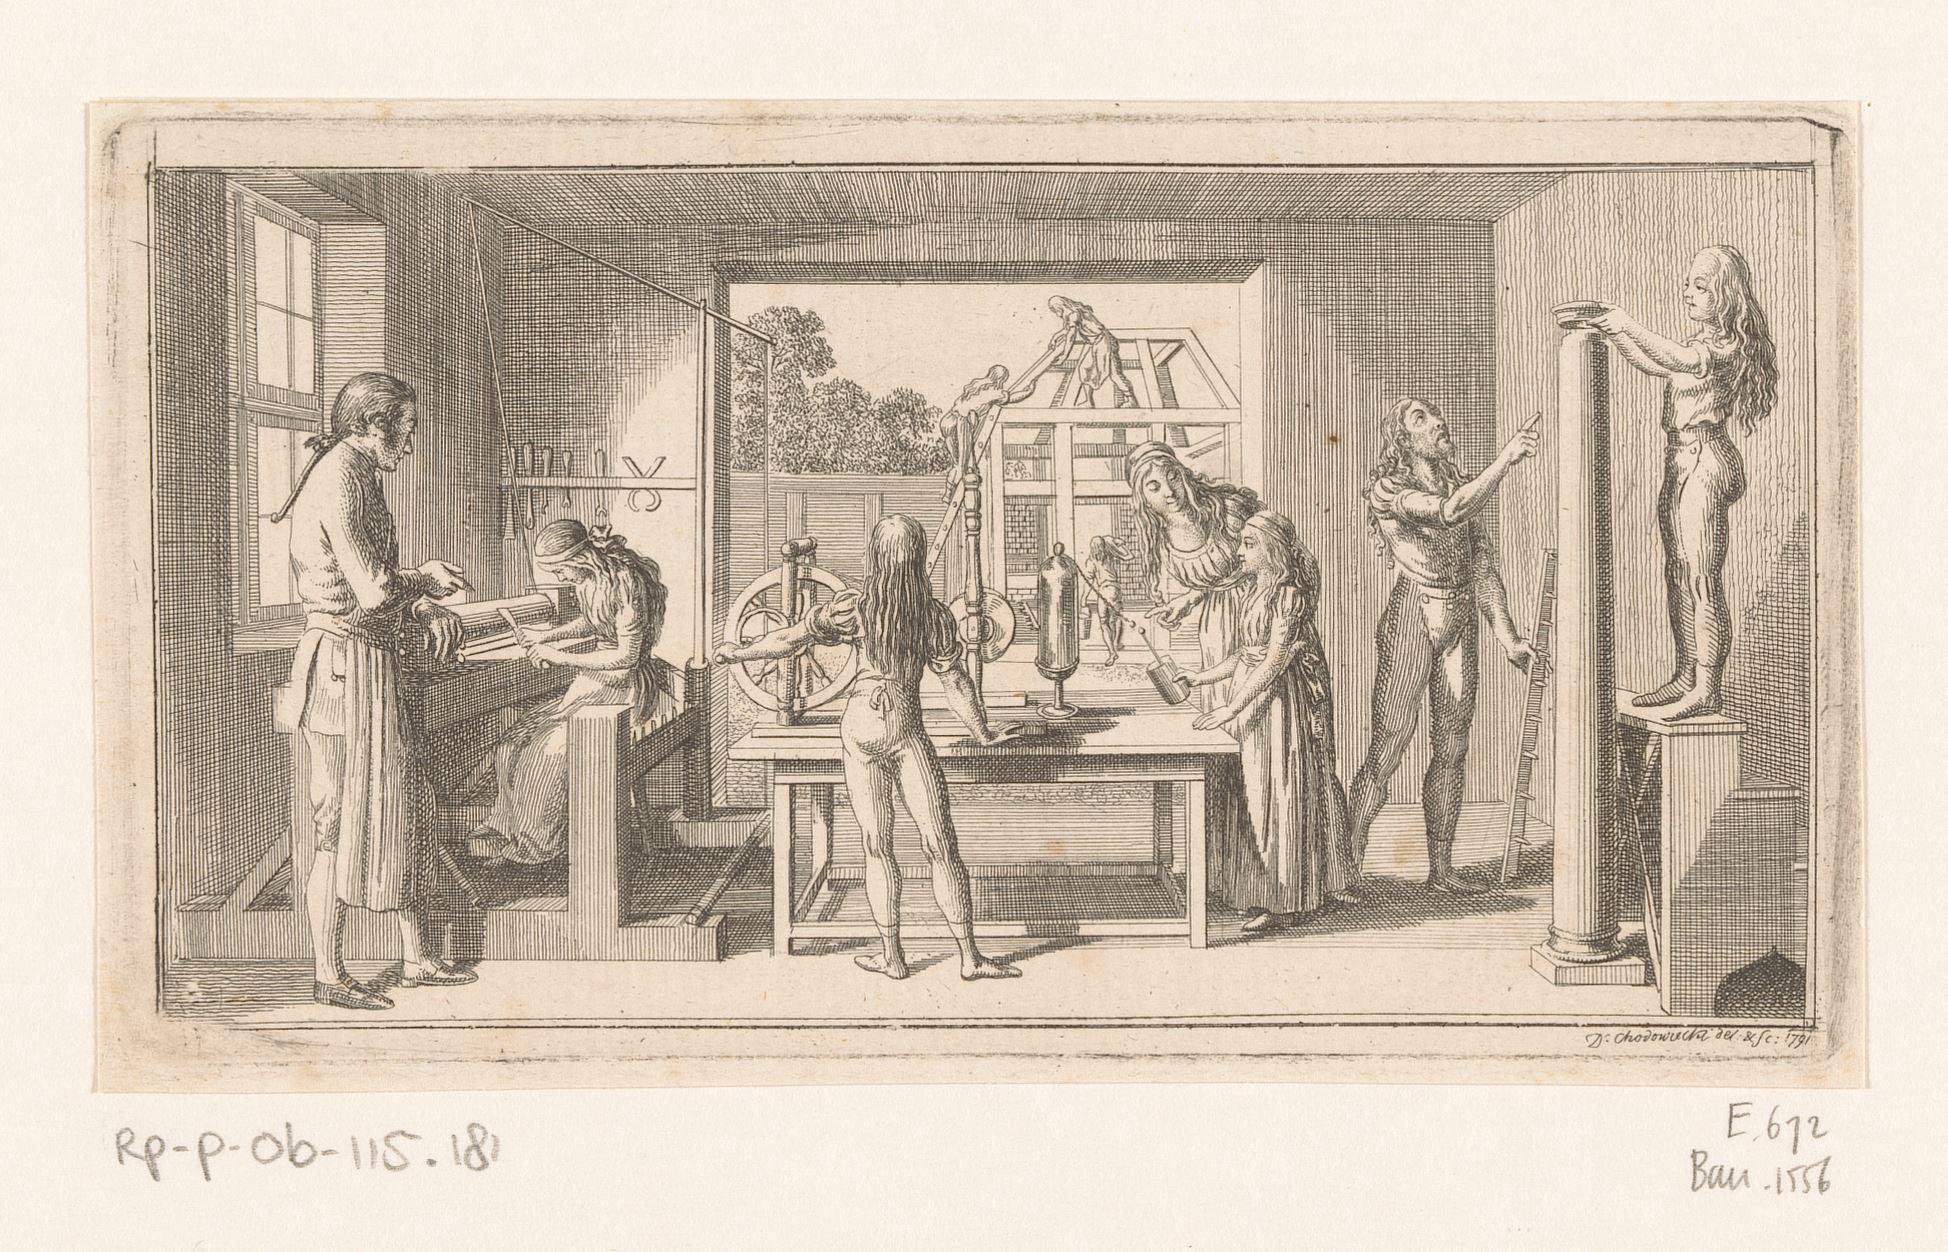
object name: print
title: Les in de werkplaats van een draaier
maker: daniel nikolaus chodowiecki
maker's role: draughtsman, print maker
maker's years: 1726-1801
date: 1791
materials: paper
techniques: etching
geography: berlin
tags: turner in wood, workbench, utopia, workshop, education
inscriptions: collector's mark: Lugt 2228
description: Prent gebruikt voor: Ziegenhagen, Franz Heirnich. Lehre von dem richtigen Verhältnis zu den Schöpfungswerken, und durch öffentliche Einfürung derselben allein bewürkende algemeine Menschbeglükkung (...). Hamburg: s.n., 1792.